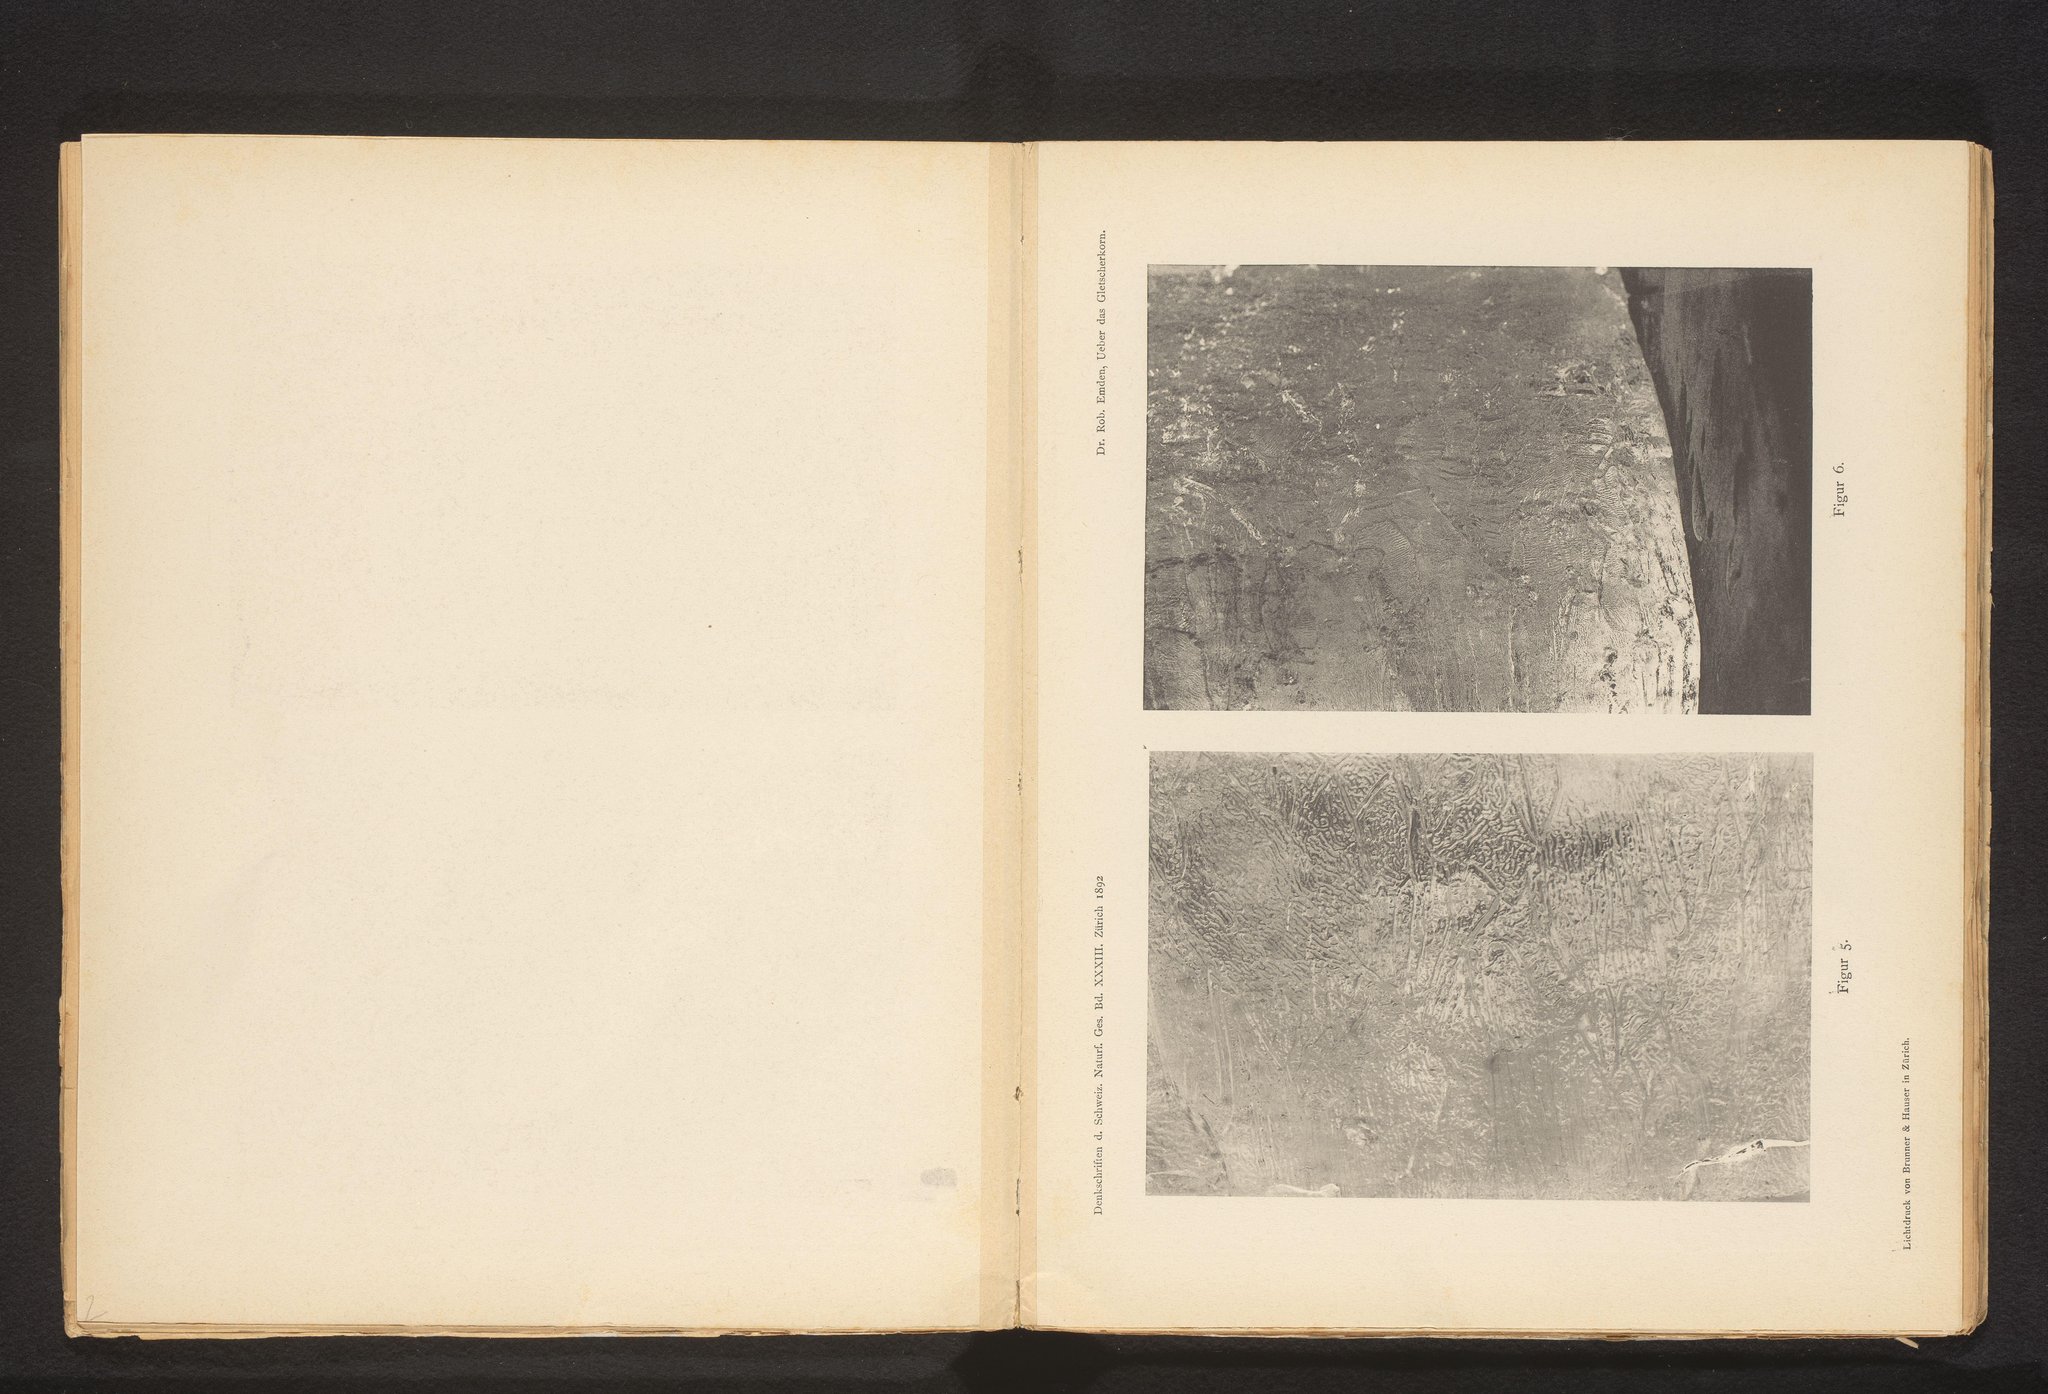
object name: page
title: Gletsjerijs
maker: Anonymous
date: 1883-1893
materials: paper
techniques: photograph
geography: zurich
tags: glacier, ice ~ state of water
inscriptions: number: ‘Figur 5. Figur 6.’